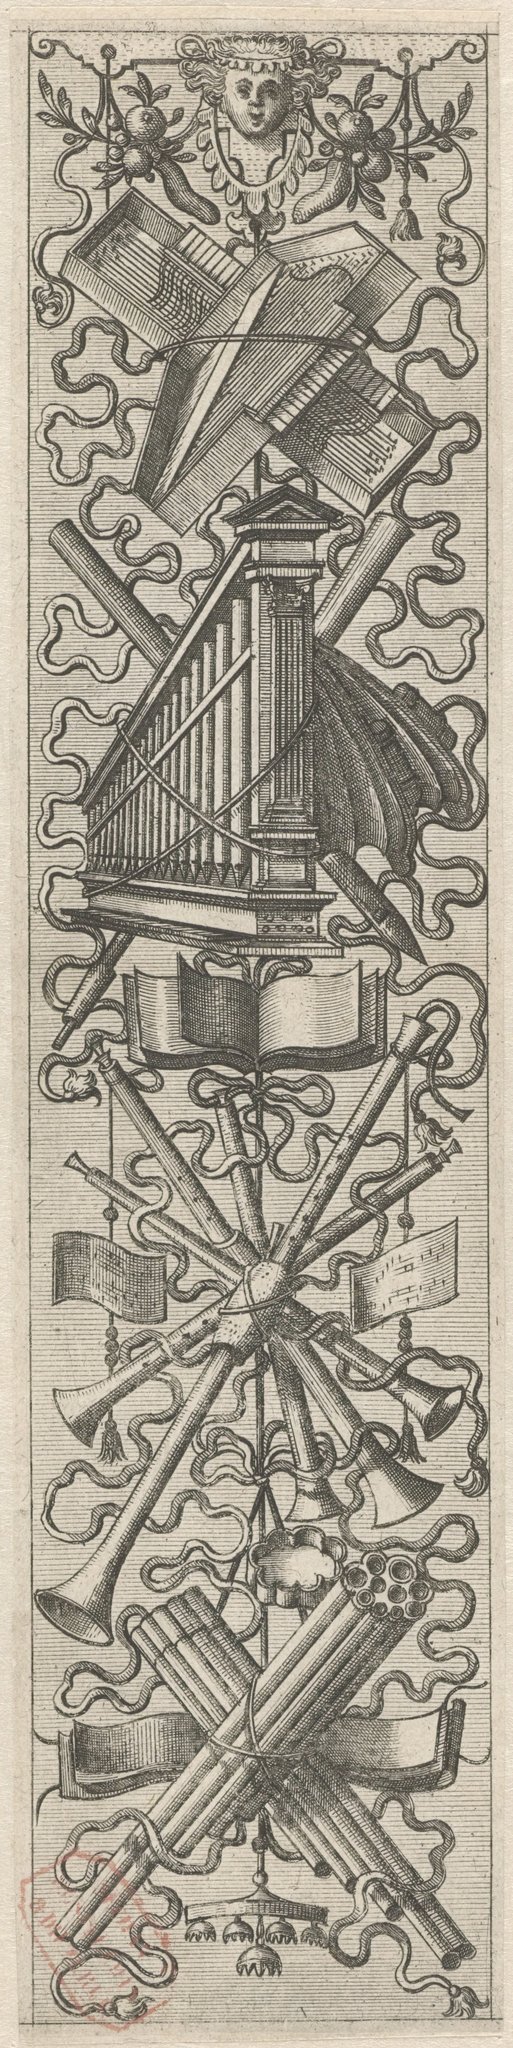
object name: print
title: Trofee van muziekinstrumenten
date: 1572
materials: paper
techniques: etching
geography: netherlands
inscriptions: collector's mark: Lugt 2275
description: Een clavichord, een portatief en schalmeien. Uit serie, bestaande uit een titelblad en 16 bladen.